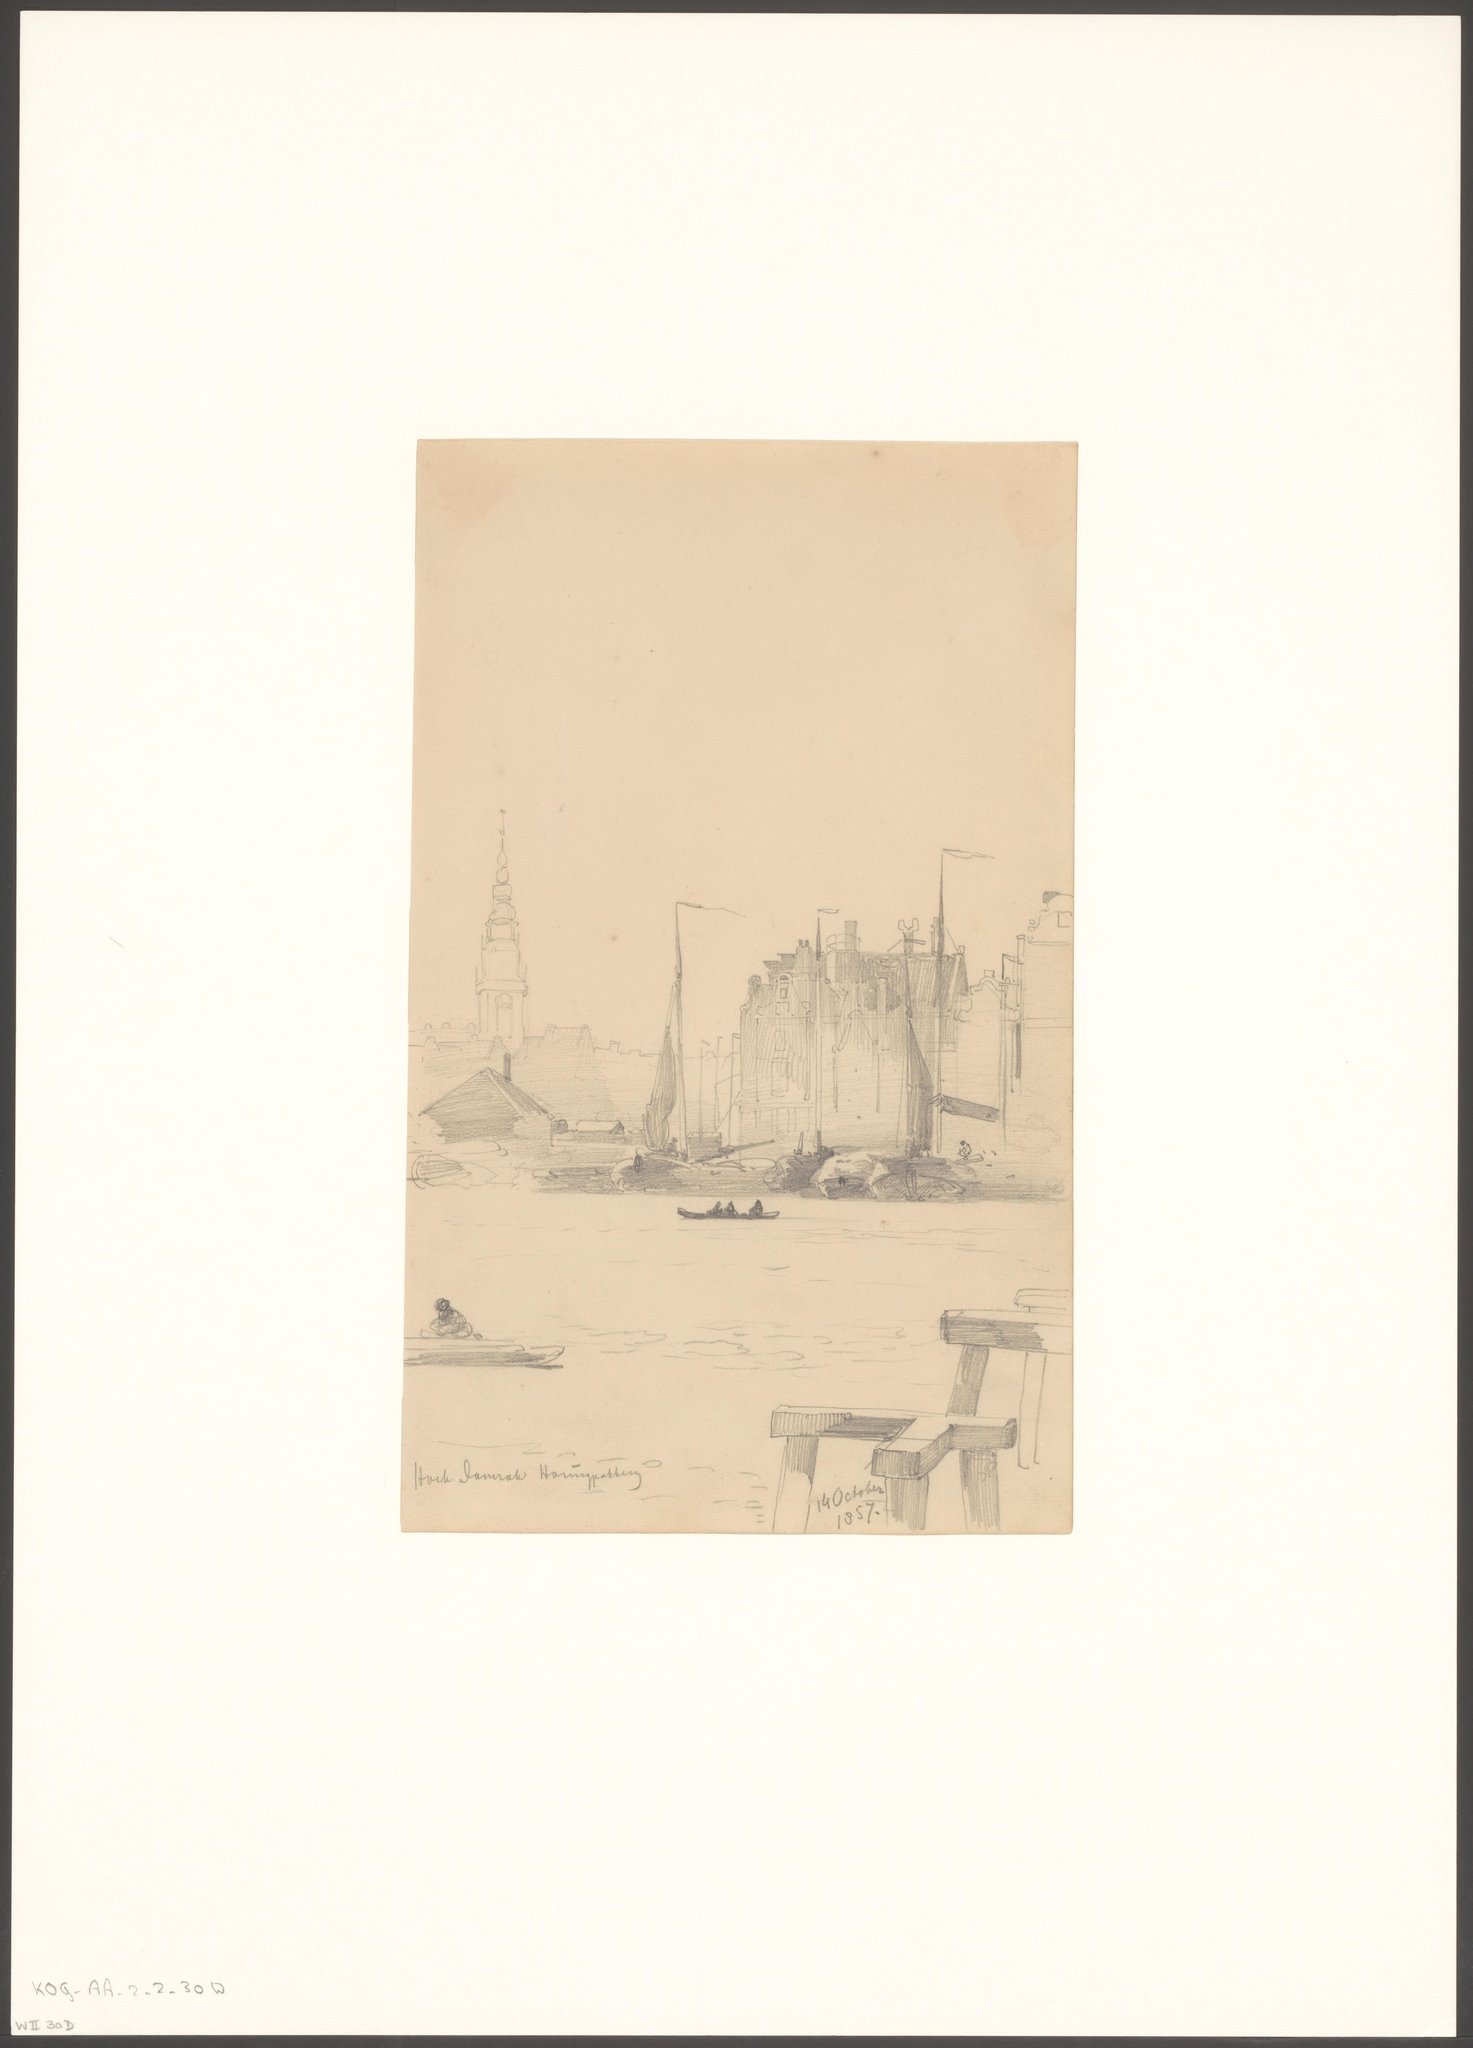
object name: drawing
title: Gezicht op de Haringpakkerij en de Oudekerkstoren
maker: willem anthonie van deventer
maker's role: draughtsman, painter, print maker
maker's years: 1824-1893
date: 1857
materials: paper, pencil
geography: amsterdam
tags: sailing-ship, sailing-boat, city-view in general; 'veduta', river, parts of church exterior and annexes: spire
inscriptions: date: ‘14 October / 1857.’, inscription: ‘Hoek Damrak Haringpakkerij’, collector's mark: Lugt 800a, name: ‘W.A. van Deventer’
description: Tekening binnen de Atlas Van Eck ingedeeld op wijknummer 2.